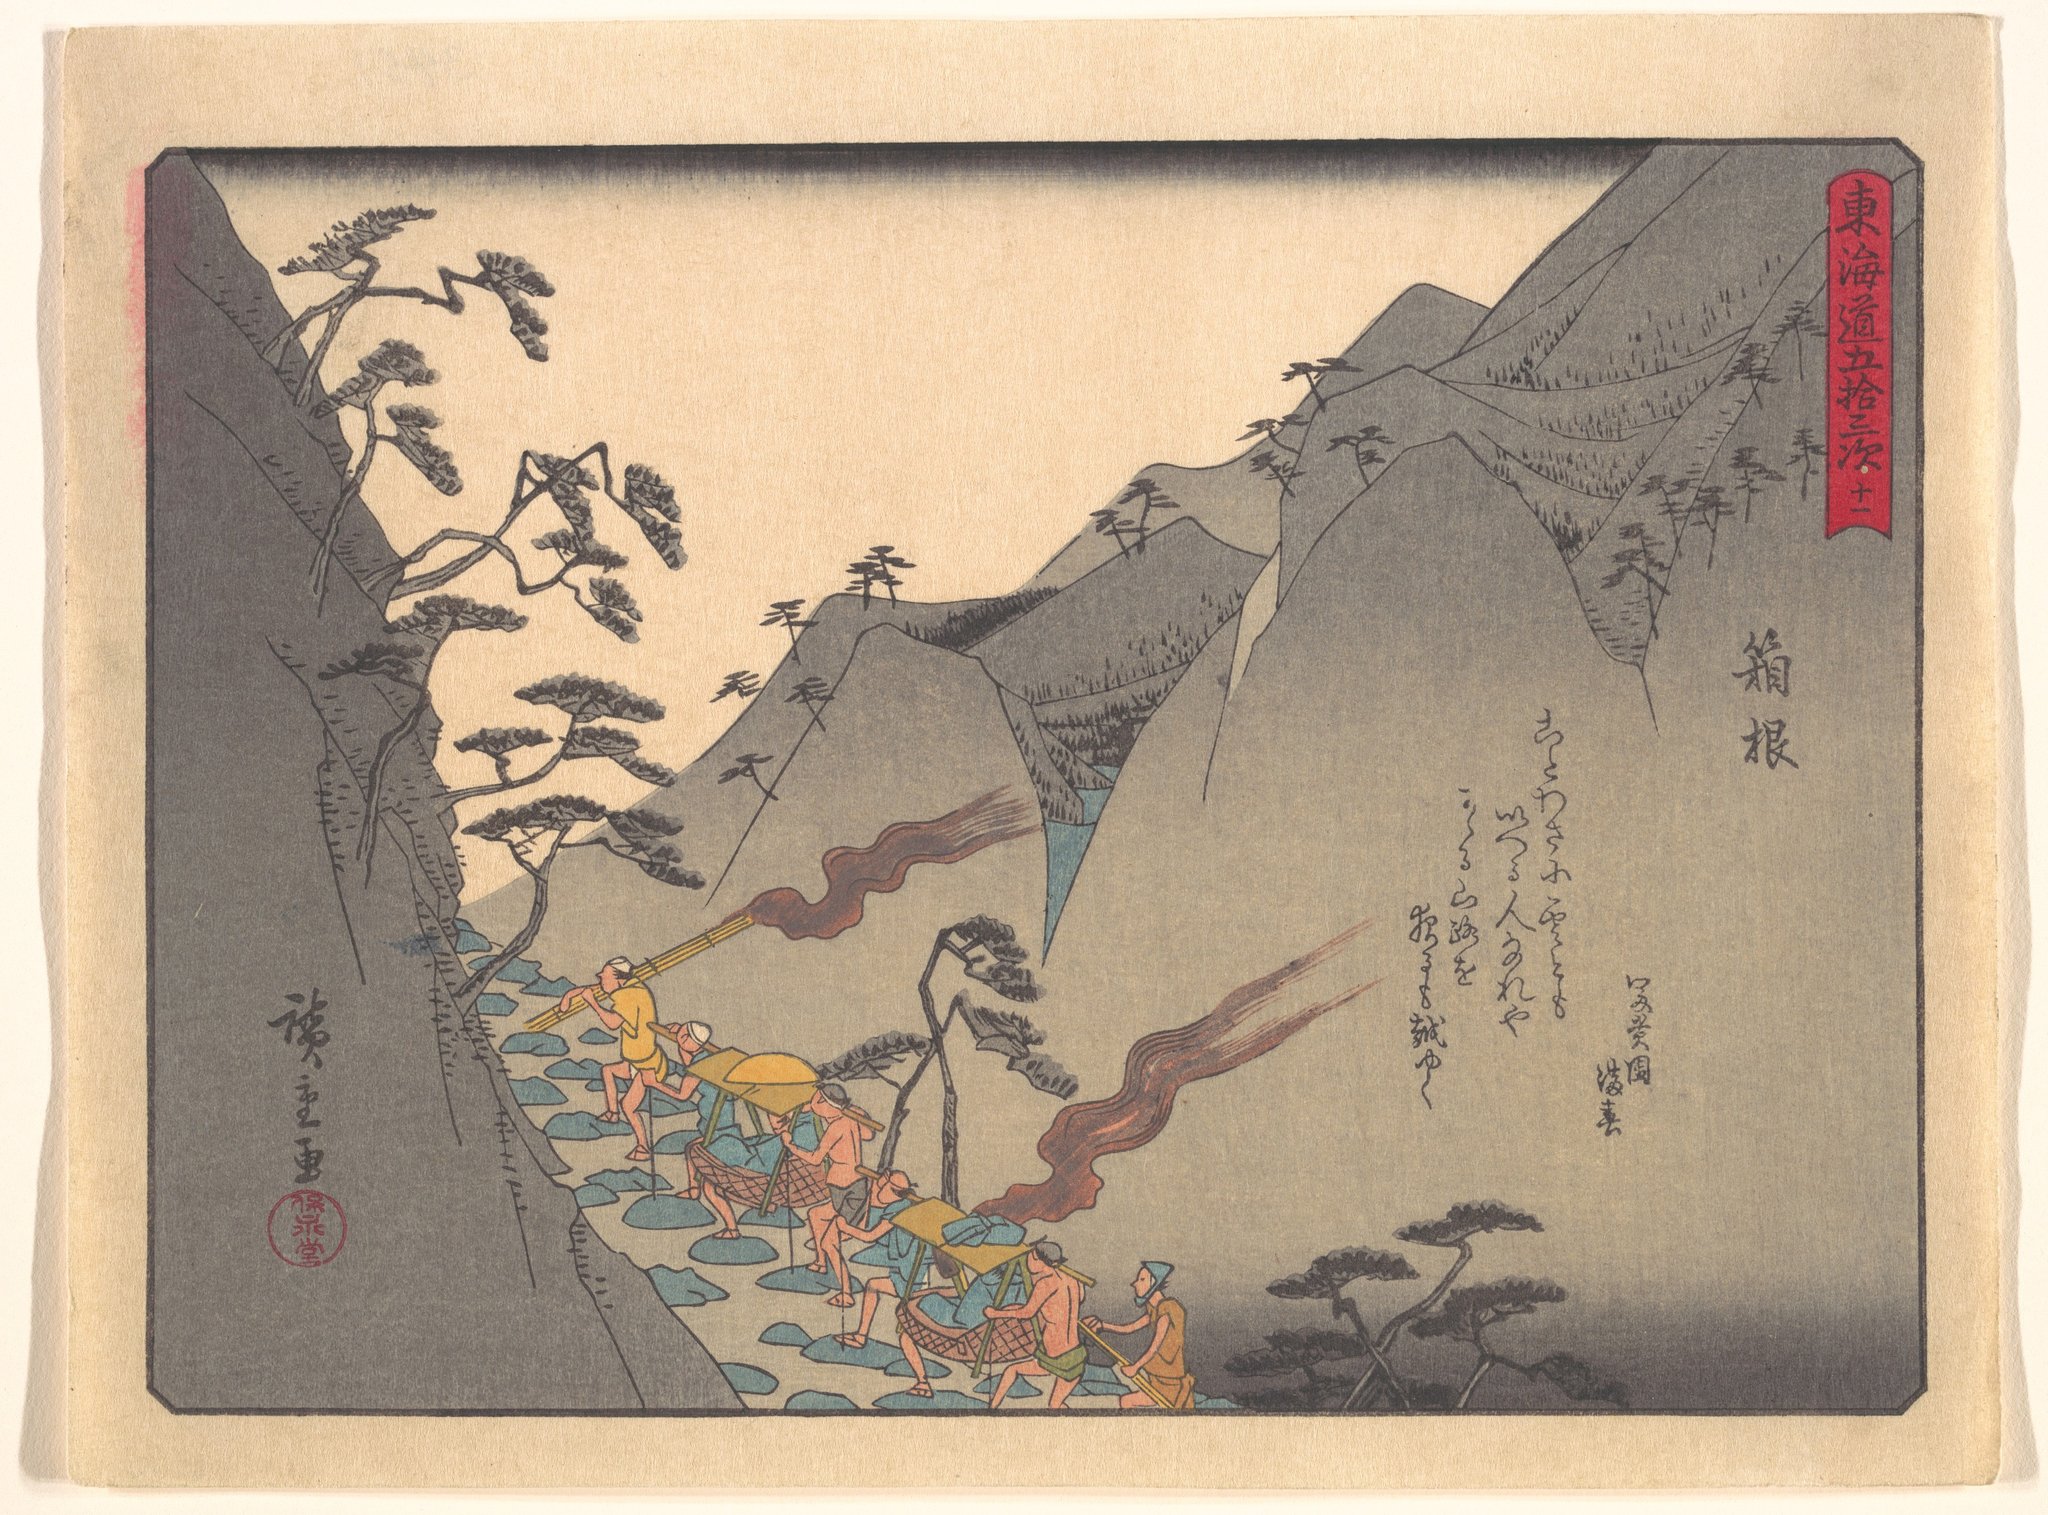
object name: print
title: 東海道五十三次 箱根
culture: japanese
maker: utagawa hiroshige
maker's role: artist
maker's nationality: japanese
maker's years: 1797-1858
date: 1901-1933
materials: ink, paper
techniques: woodblock print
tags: men,mountains,trees